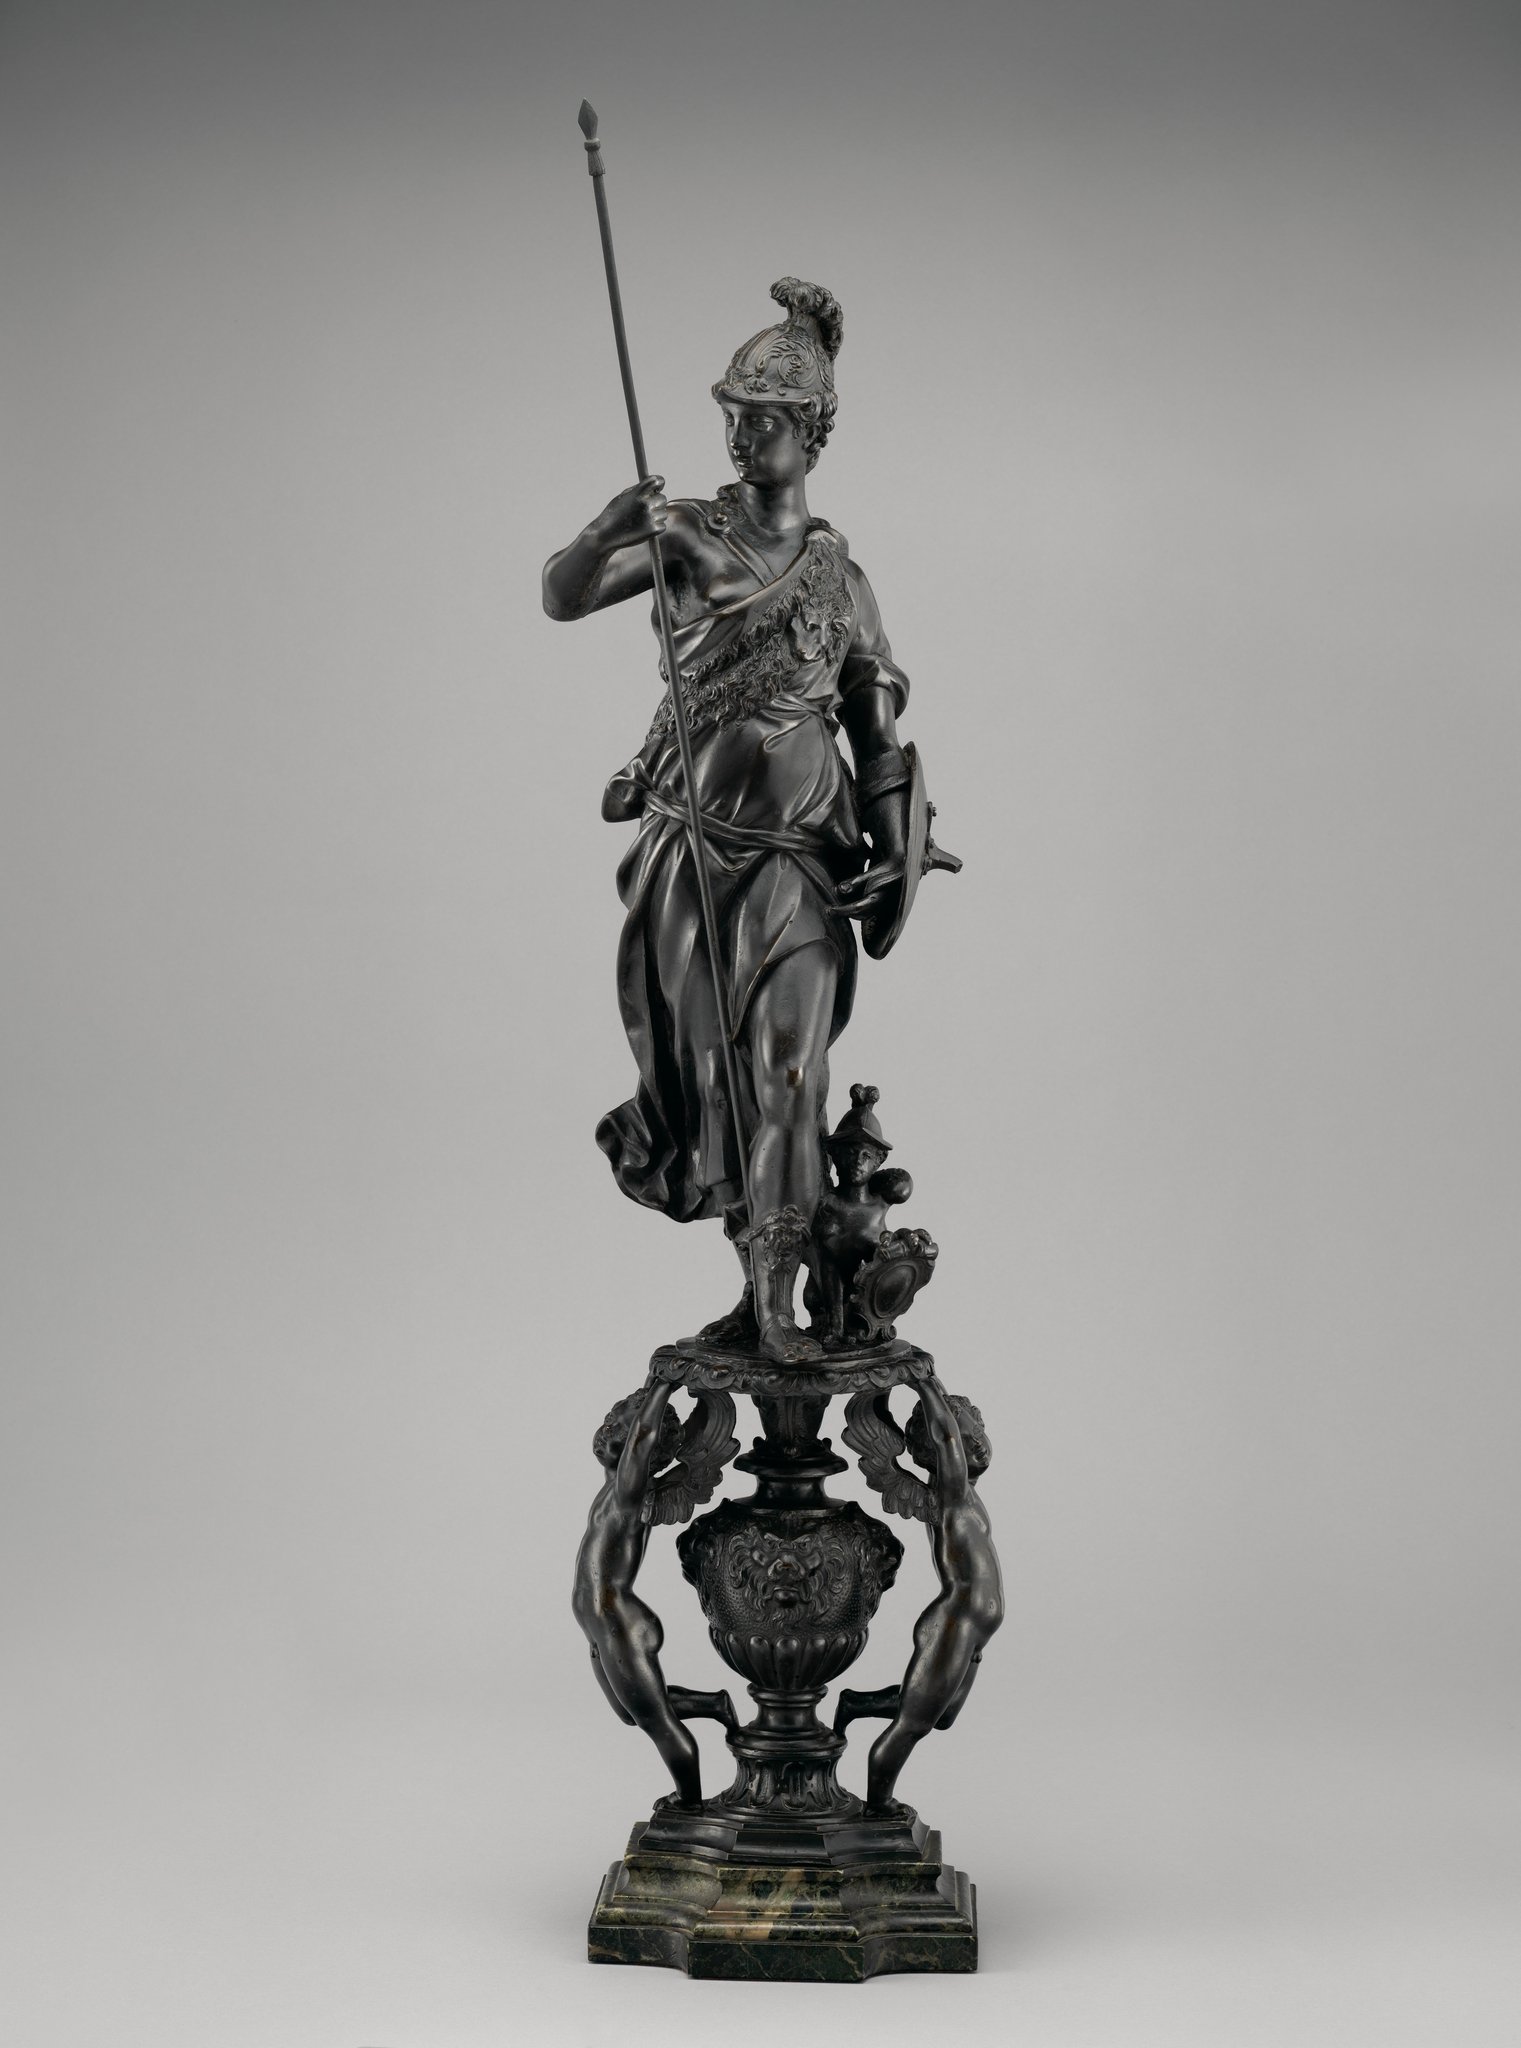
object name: andiron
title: Andiron with figure of Minerva (allegory of War) (one of a pair)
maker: girolamo campagna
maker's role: artist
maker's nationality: italian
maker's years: 1549-1625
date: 1601-1700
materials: bronze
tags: spears,women,allegory